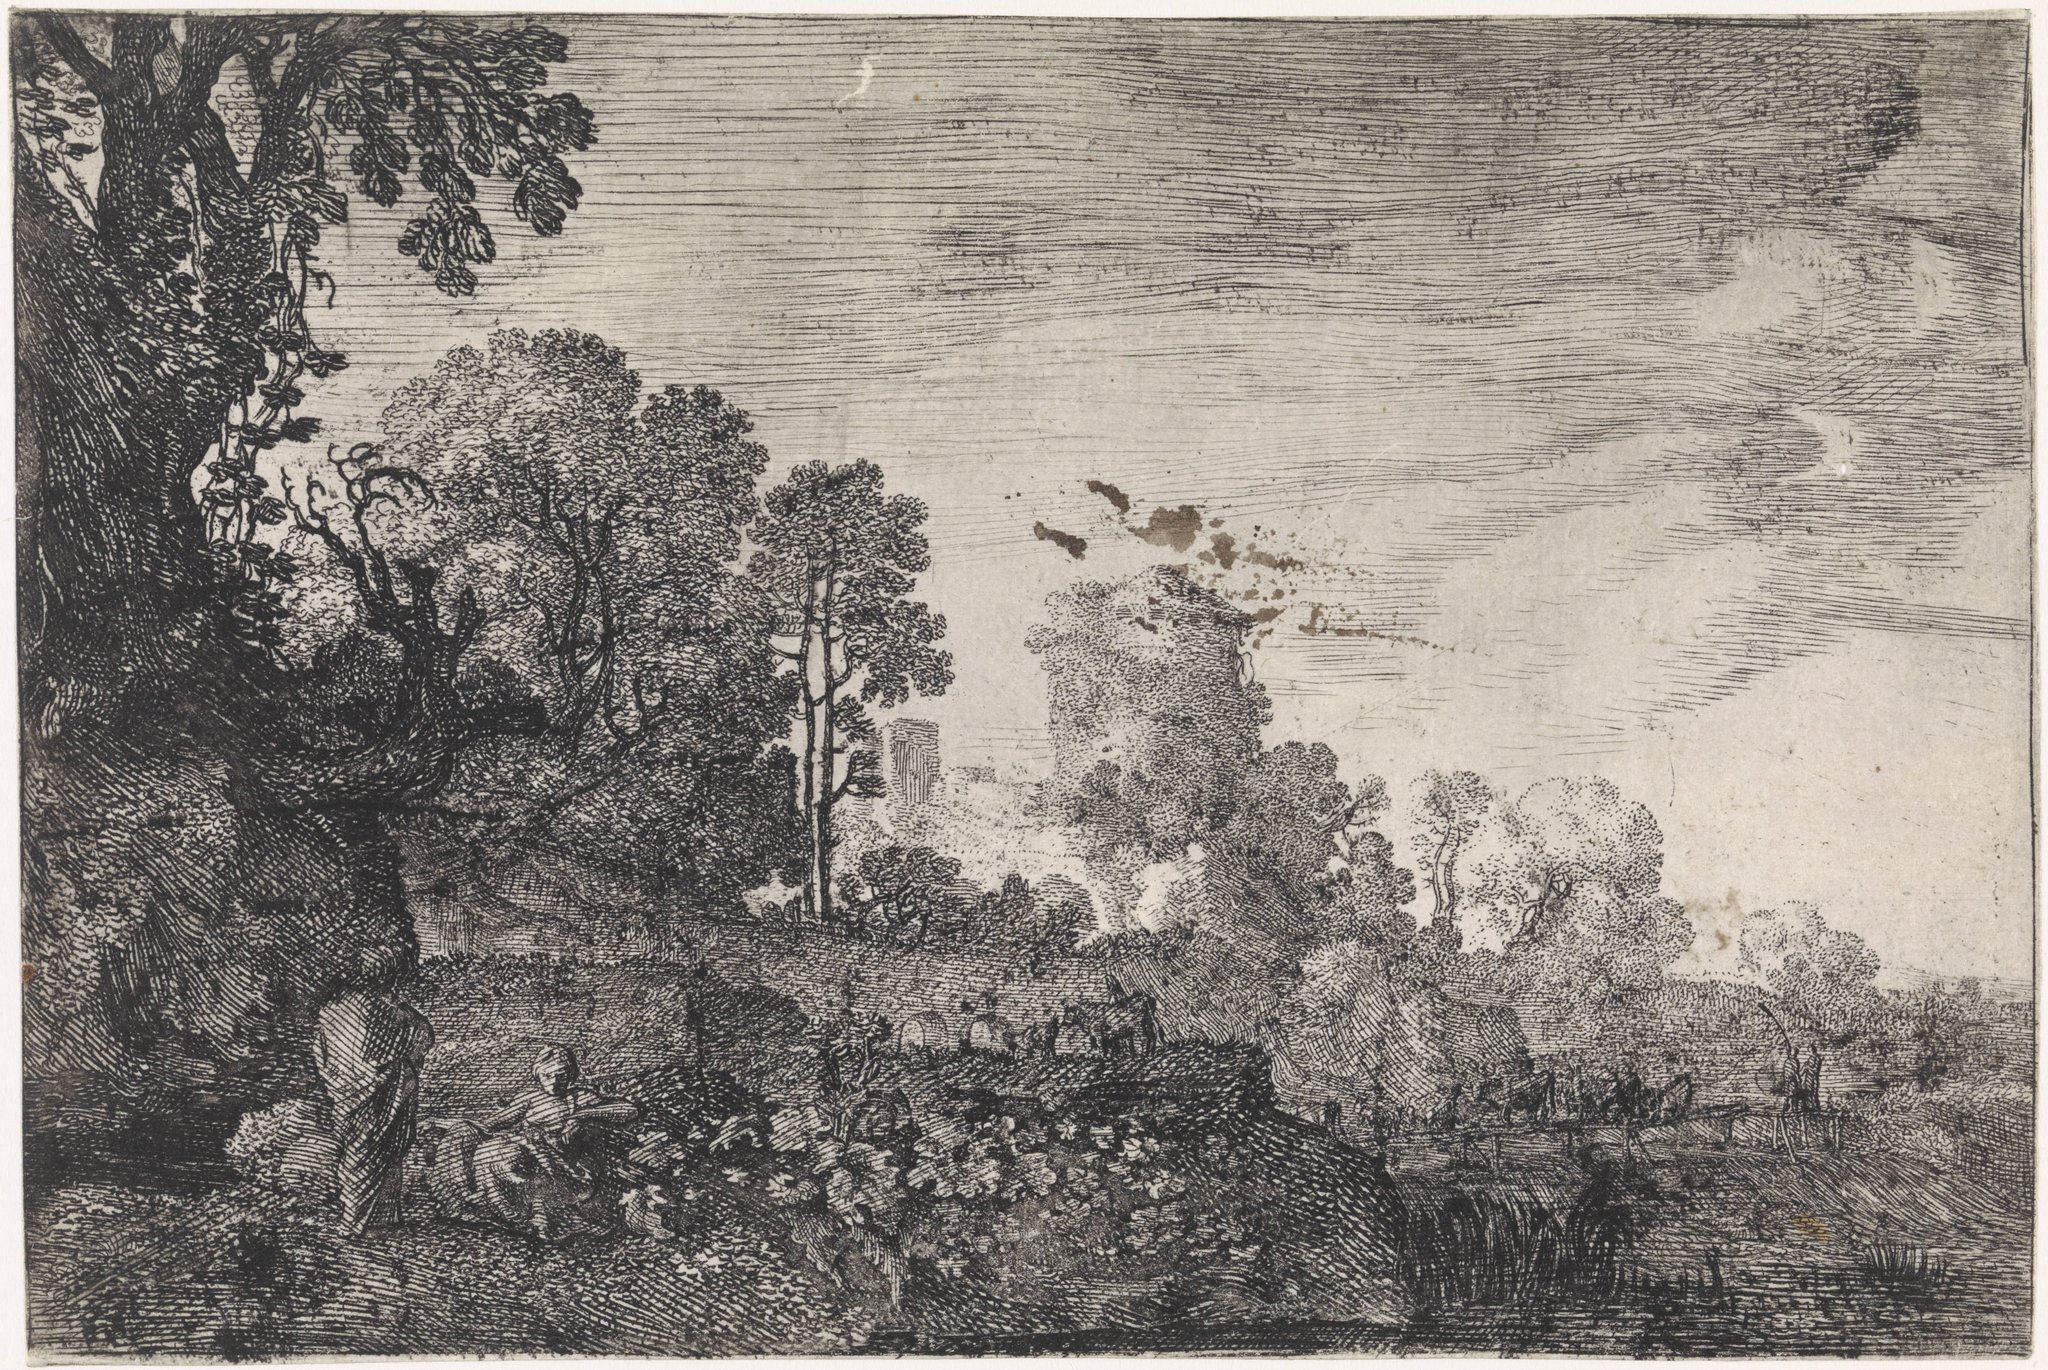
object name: print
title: Landschap met een kudde op een brug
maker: moyses van wtenbrouck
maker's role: painter, print maker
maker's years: 1590-1647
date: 1600-1647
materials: paper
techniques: engraving, etching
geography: the hague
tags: pastorals, arcadian scenes, herd, flock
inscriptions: collector's mark: Lugt 2165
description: Een kudde met herders trekt over een eenvoudige houten brug, die over een brede waterval voert. Daarachter staat een stenen boogbrug en een hoge, ronde toren. Op de voorgrond een man en een vrouw.